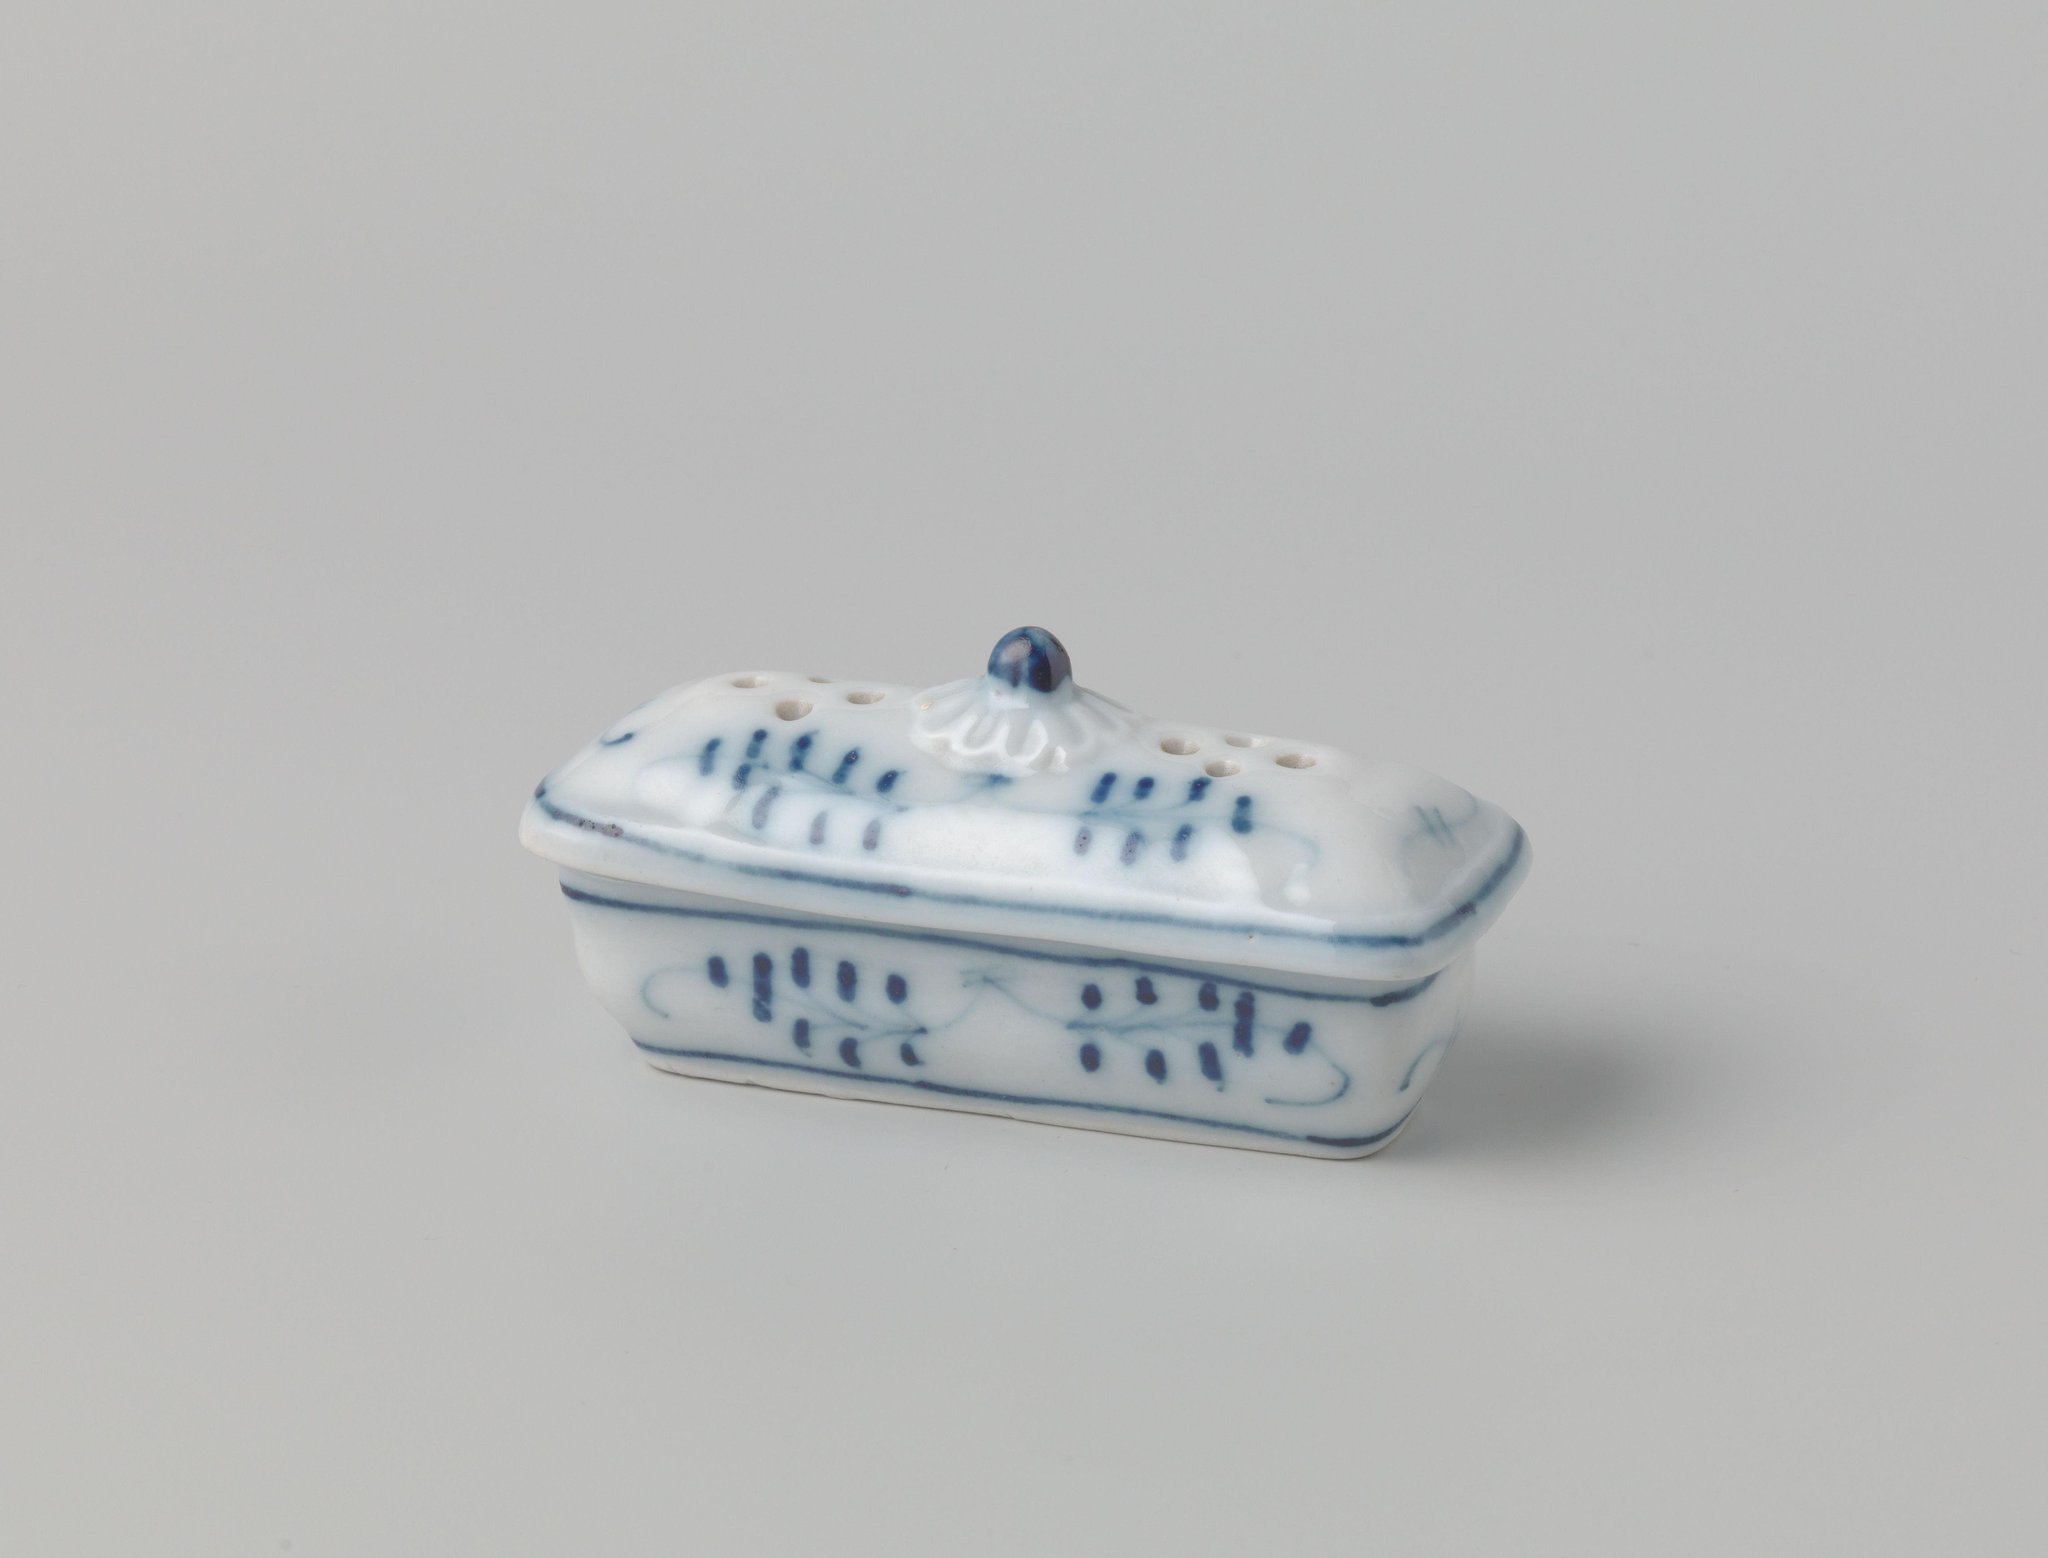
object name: wastafelservies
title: Deksel van tandenschuierbakje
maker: Anonymous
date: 1775-1800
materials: ceramic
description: Deksel van een tandenschuierbakje met blauw Saksisch patroon, ongemerkt.